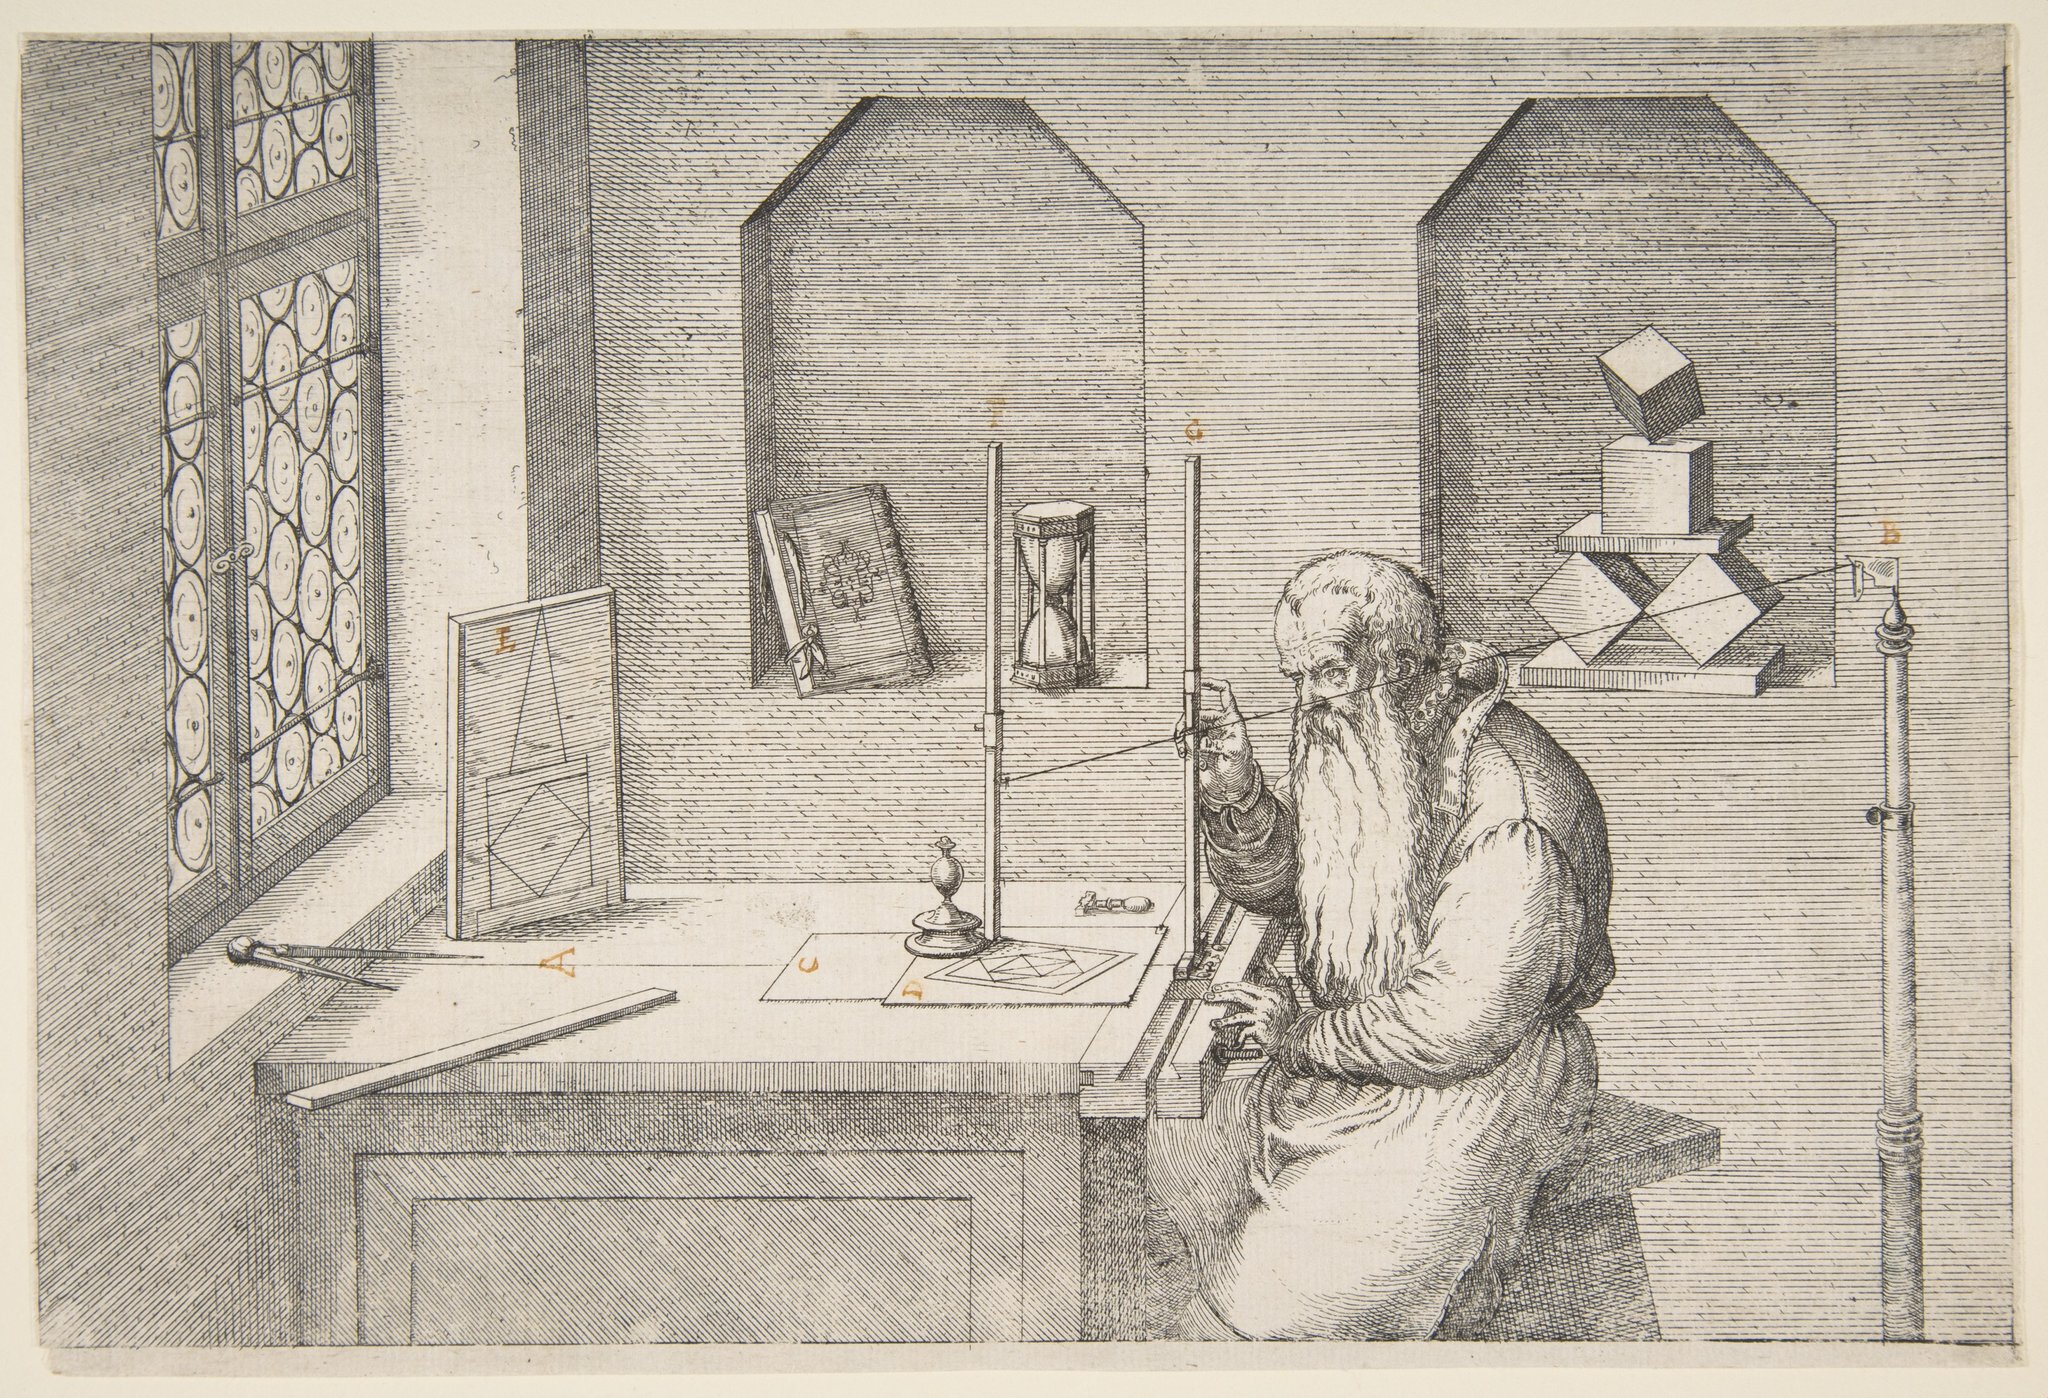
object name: print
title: Wenzel Jamnitzer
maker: jost amman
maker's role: artist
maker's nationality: swiss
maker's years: 1539-1591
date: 1501-1600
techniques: etching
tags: men,hourglass,compass